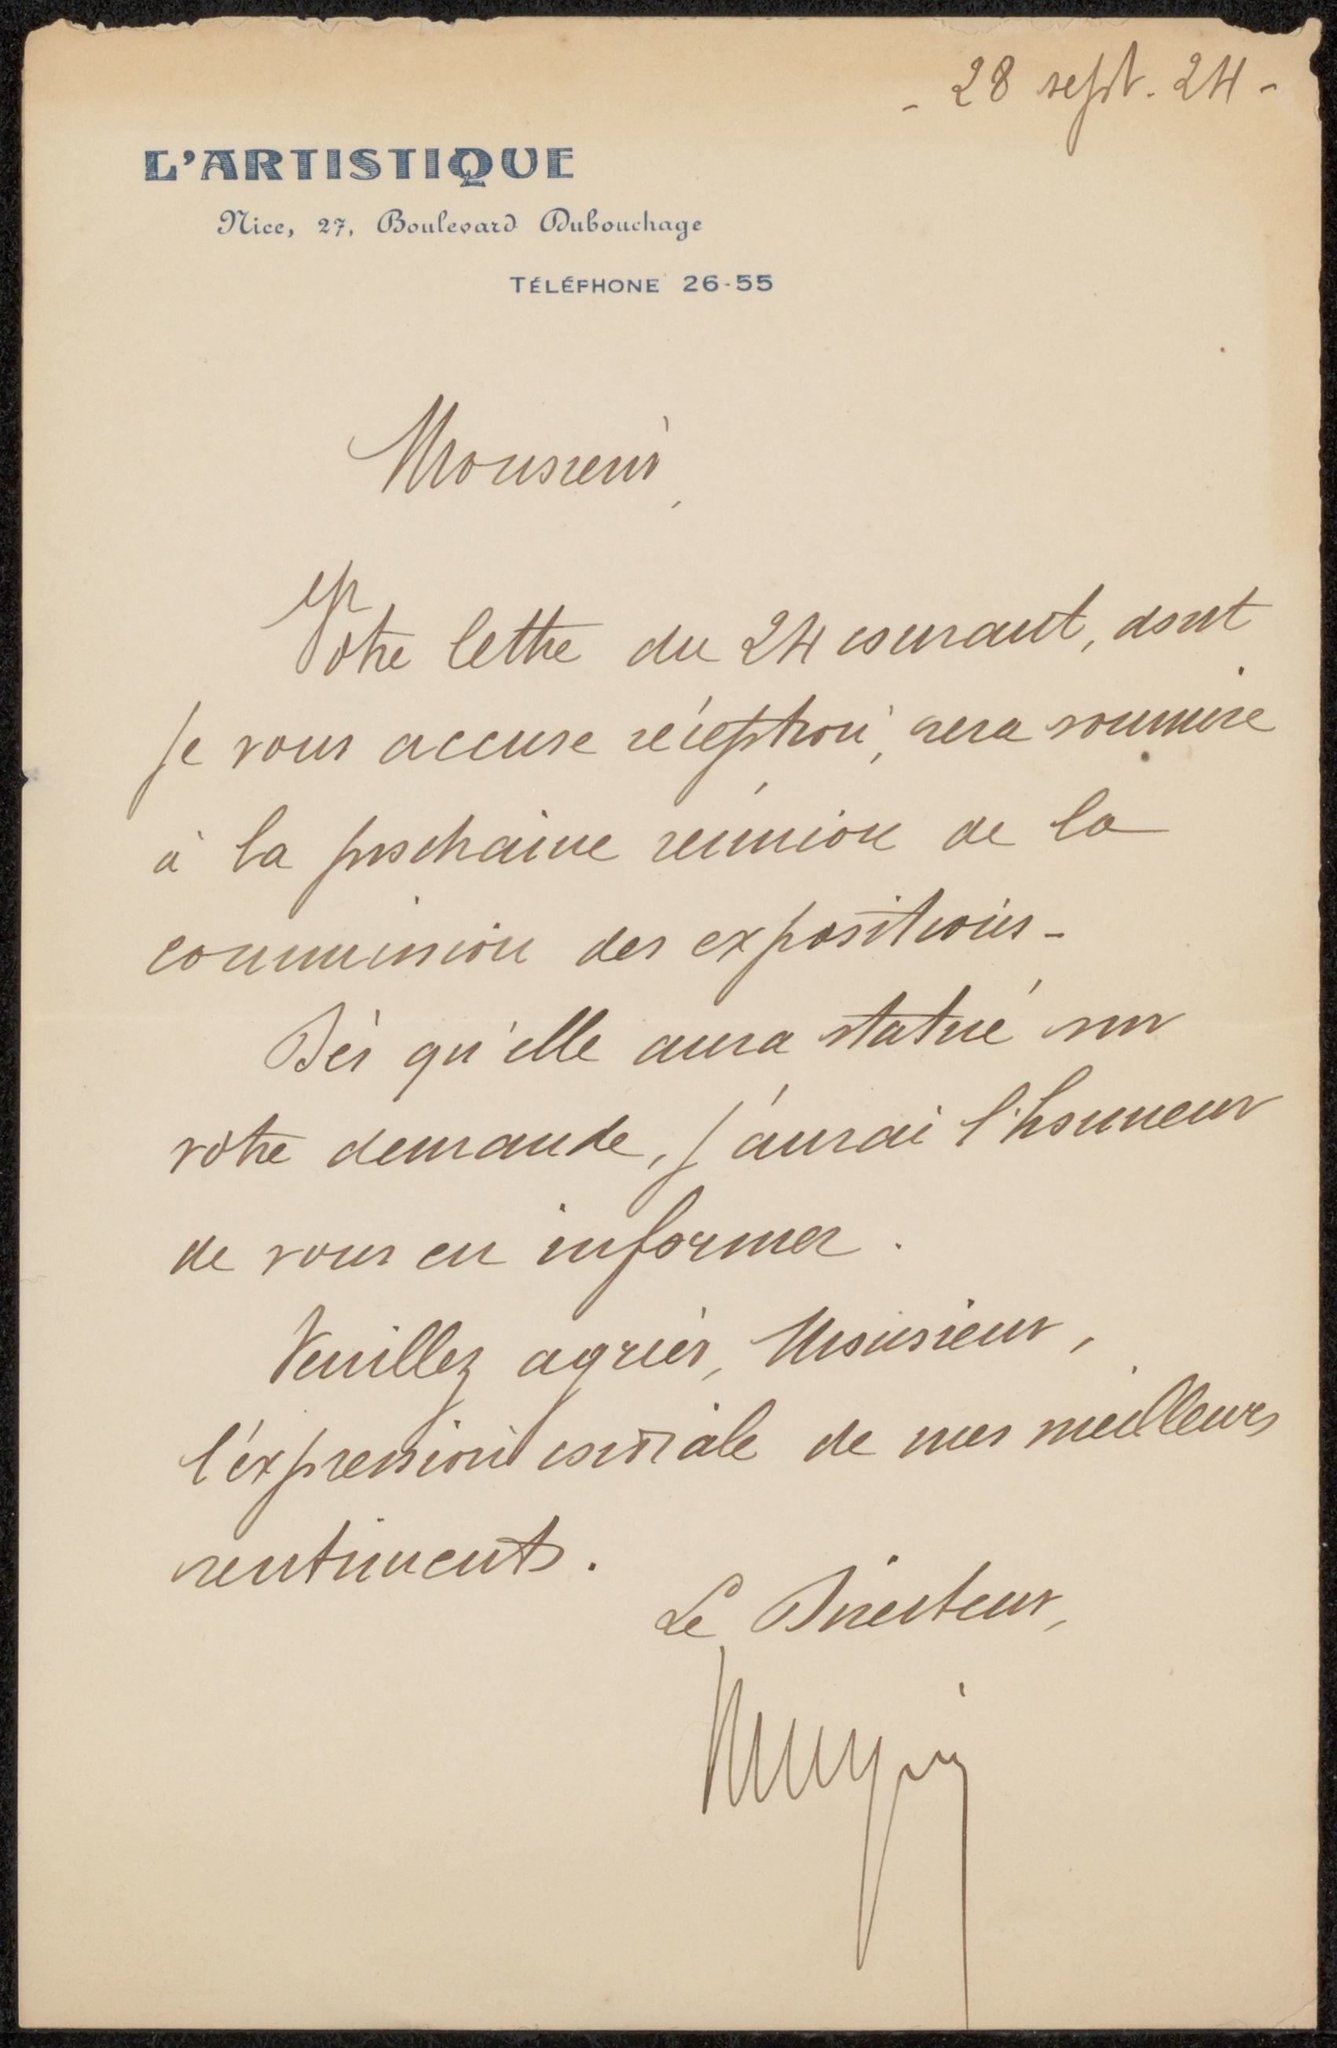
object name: letter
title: Brief aan Philip Zilcken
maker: Anonymous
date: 1924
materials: ink, paper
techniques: pen, printing, typewriting, writing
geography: nice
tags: the hague, painter, draughtsman, philip zilcken, exhibition ~ art